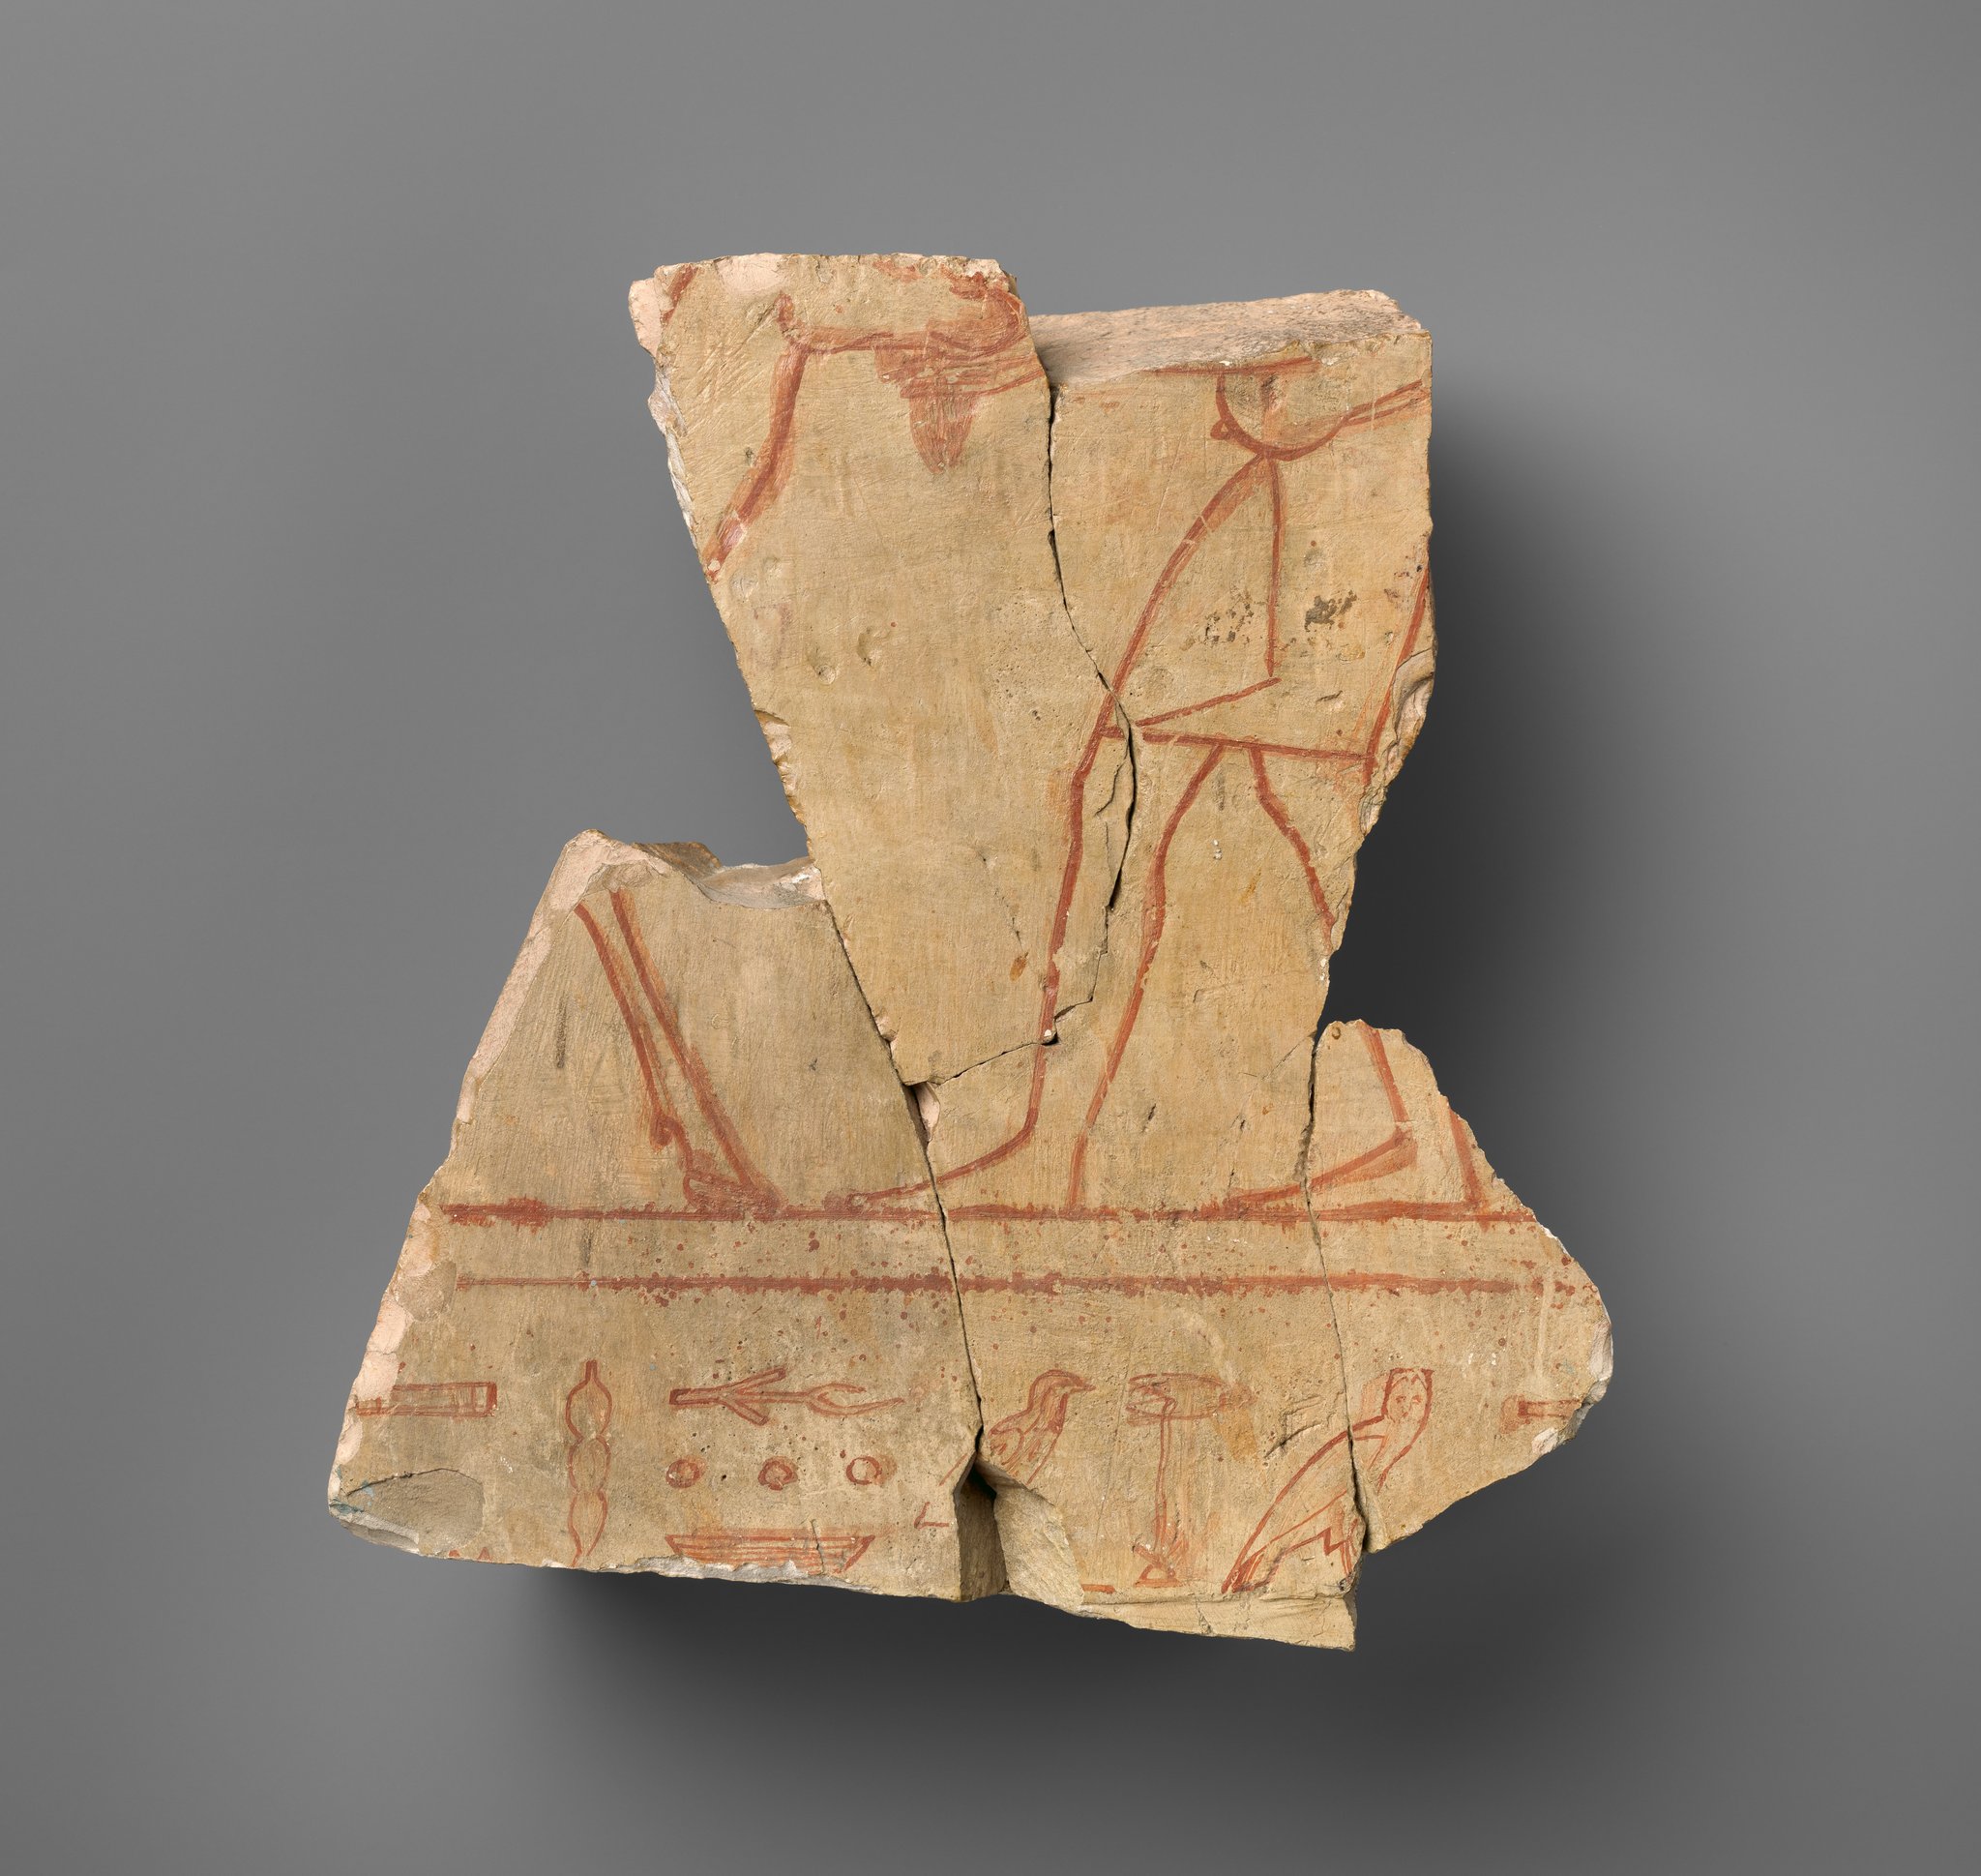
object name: relief, tomb of nespekashuty, drawing, herdsman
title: Drawing of a man and oryx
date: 656-610 BCE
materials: limestone, pigment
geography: egypt